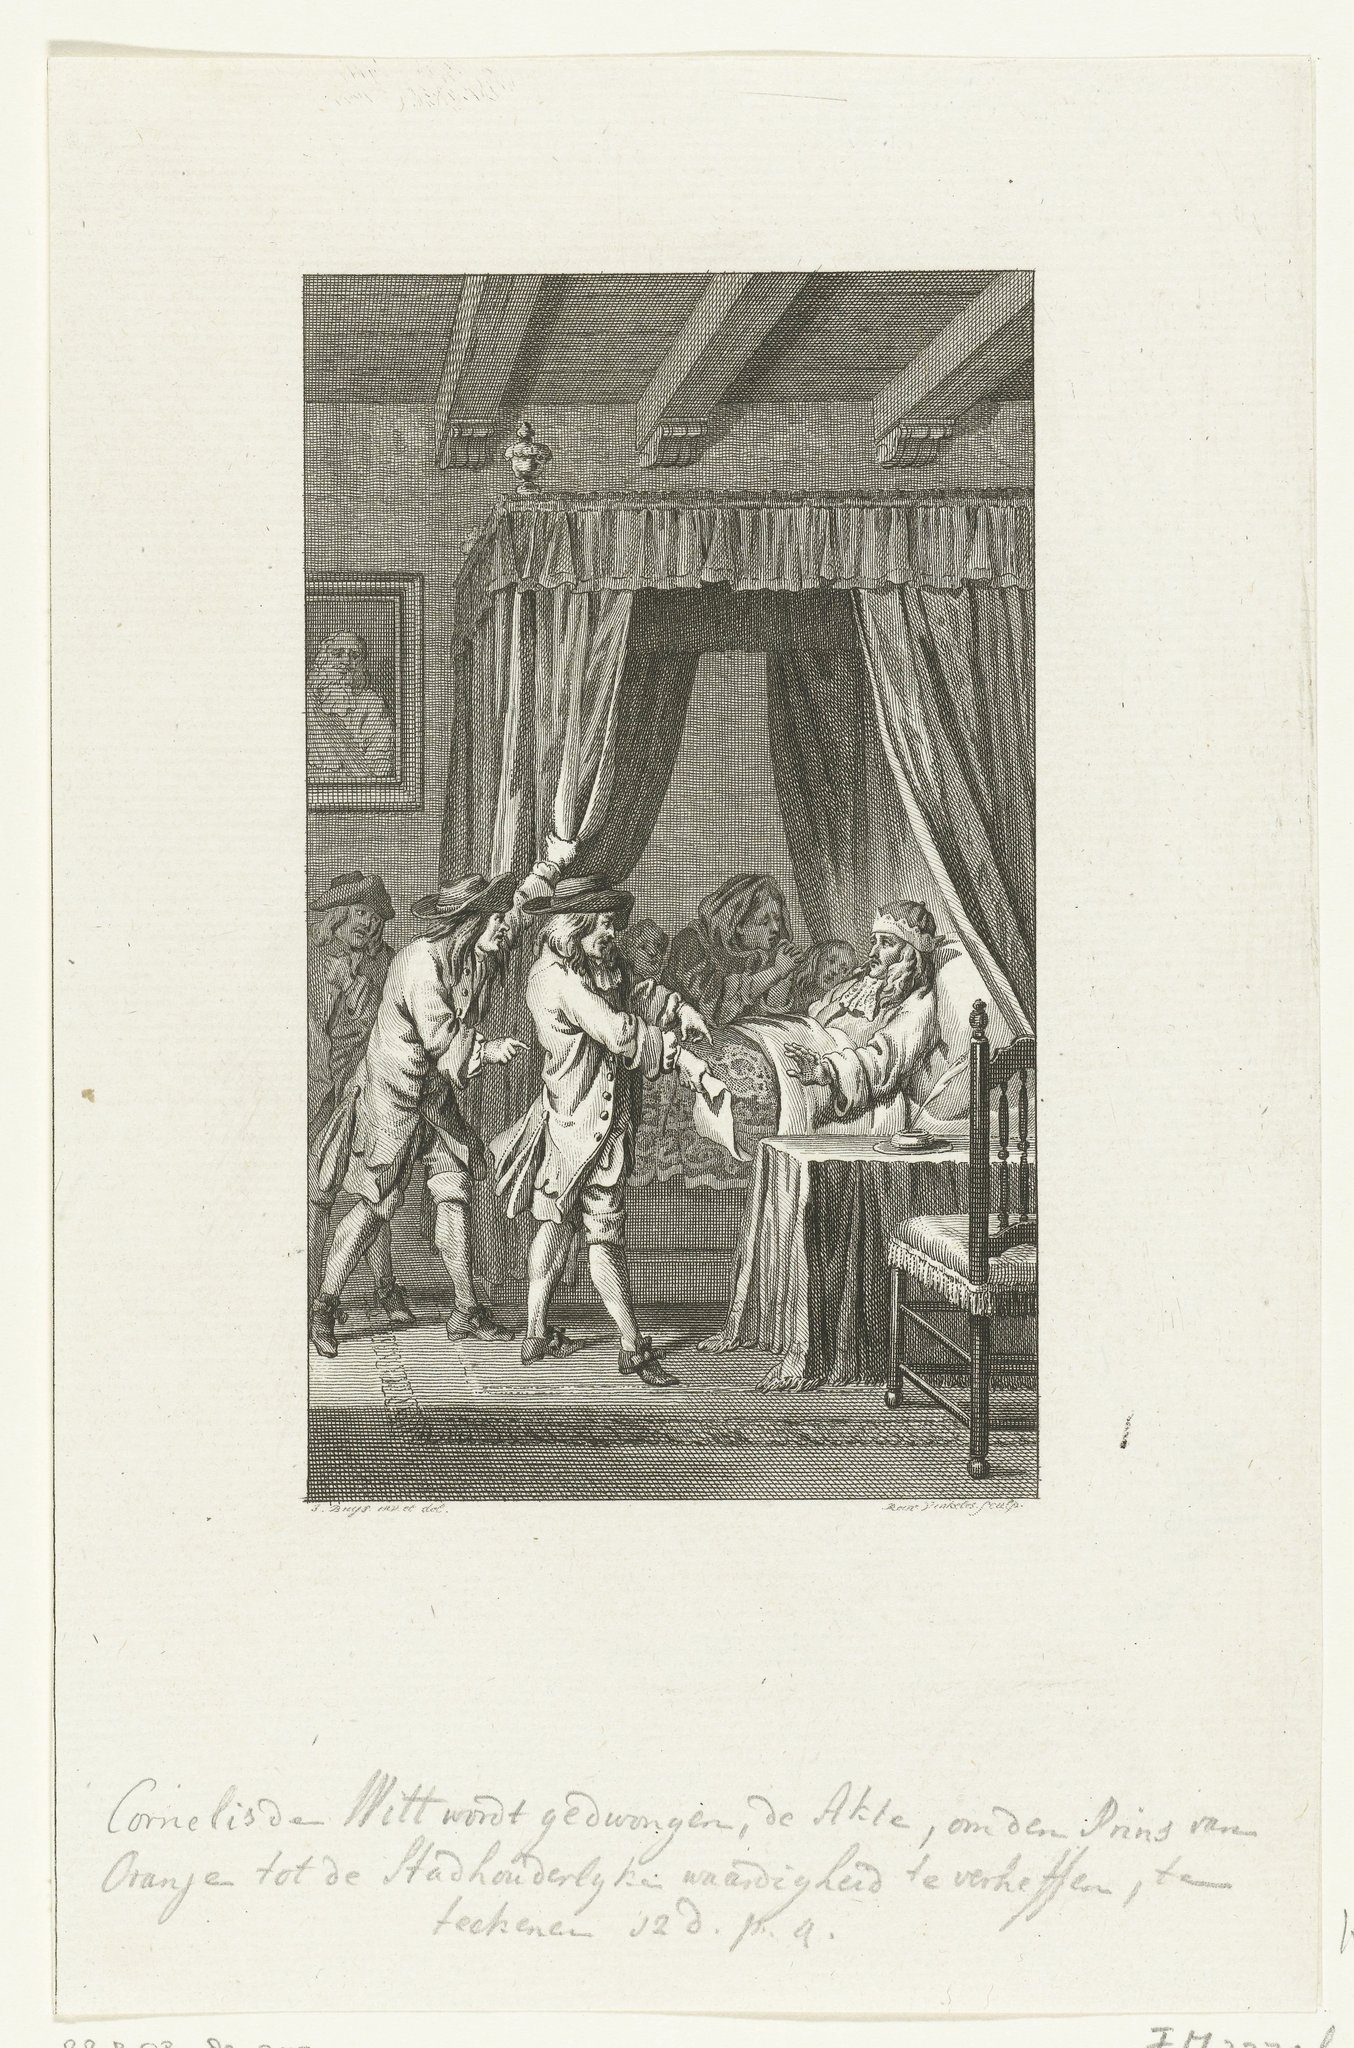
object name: history print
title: Burgers van Dordrecht dwingen Cornelis de Witt het Eeuwig Edict in te trekken, 1672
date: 1789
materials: paper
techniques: etching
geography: northern netherlands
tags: cornelis de witt, dordrecht, rampjaar (disaster year)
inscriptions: collector's mark: Lugt 240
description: Gebruikt als illustratie in: Jacobus Kok, Vaderlandsch Woordenboek, Johannes Allart, Amsterdam 1785-1799, 35 delen, dl. XII, pl. IV.